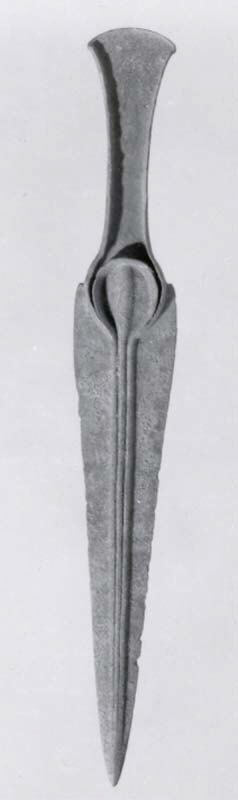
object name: dagger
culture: iranian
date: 1000-801 BCE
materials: bronze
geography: northwestern iran, caspian region